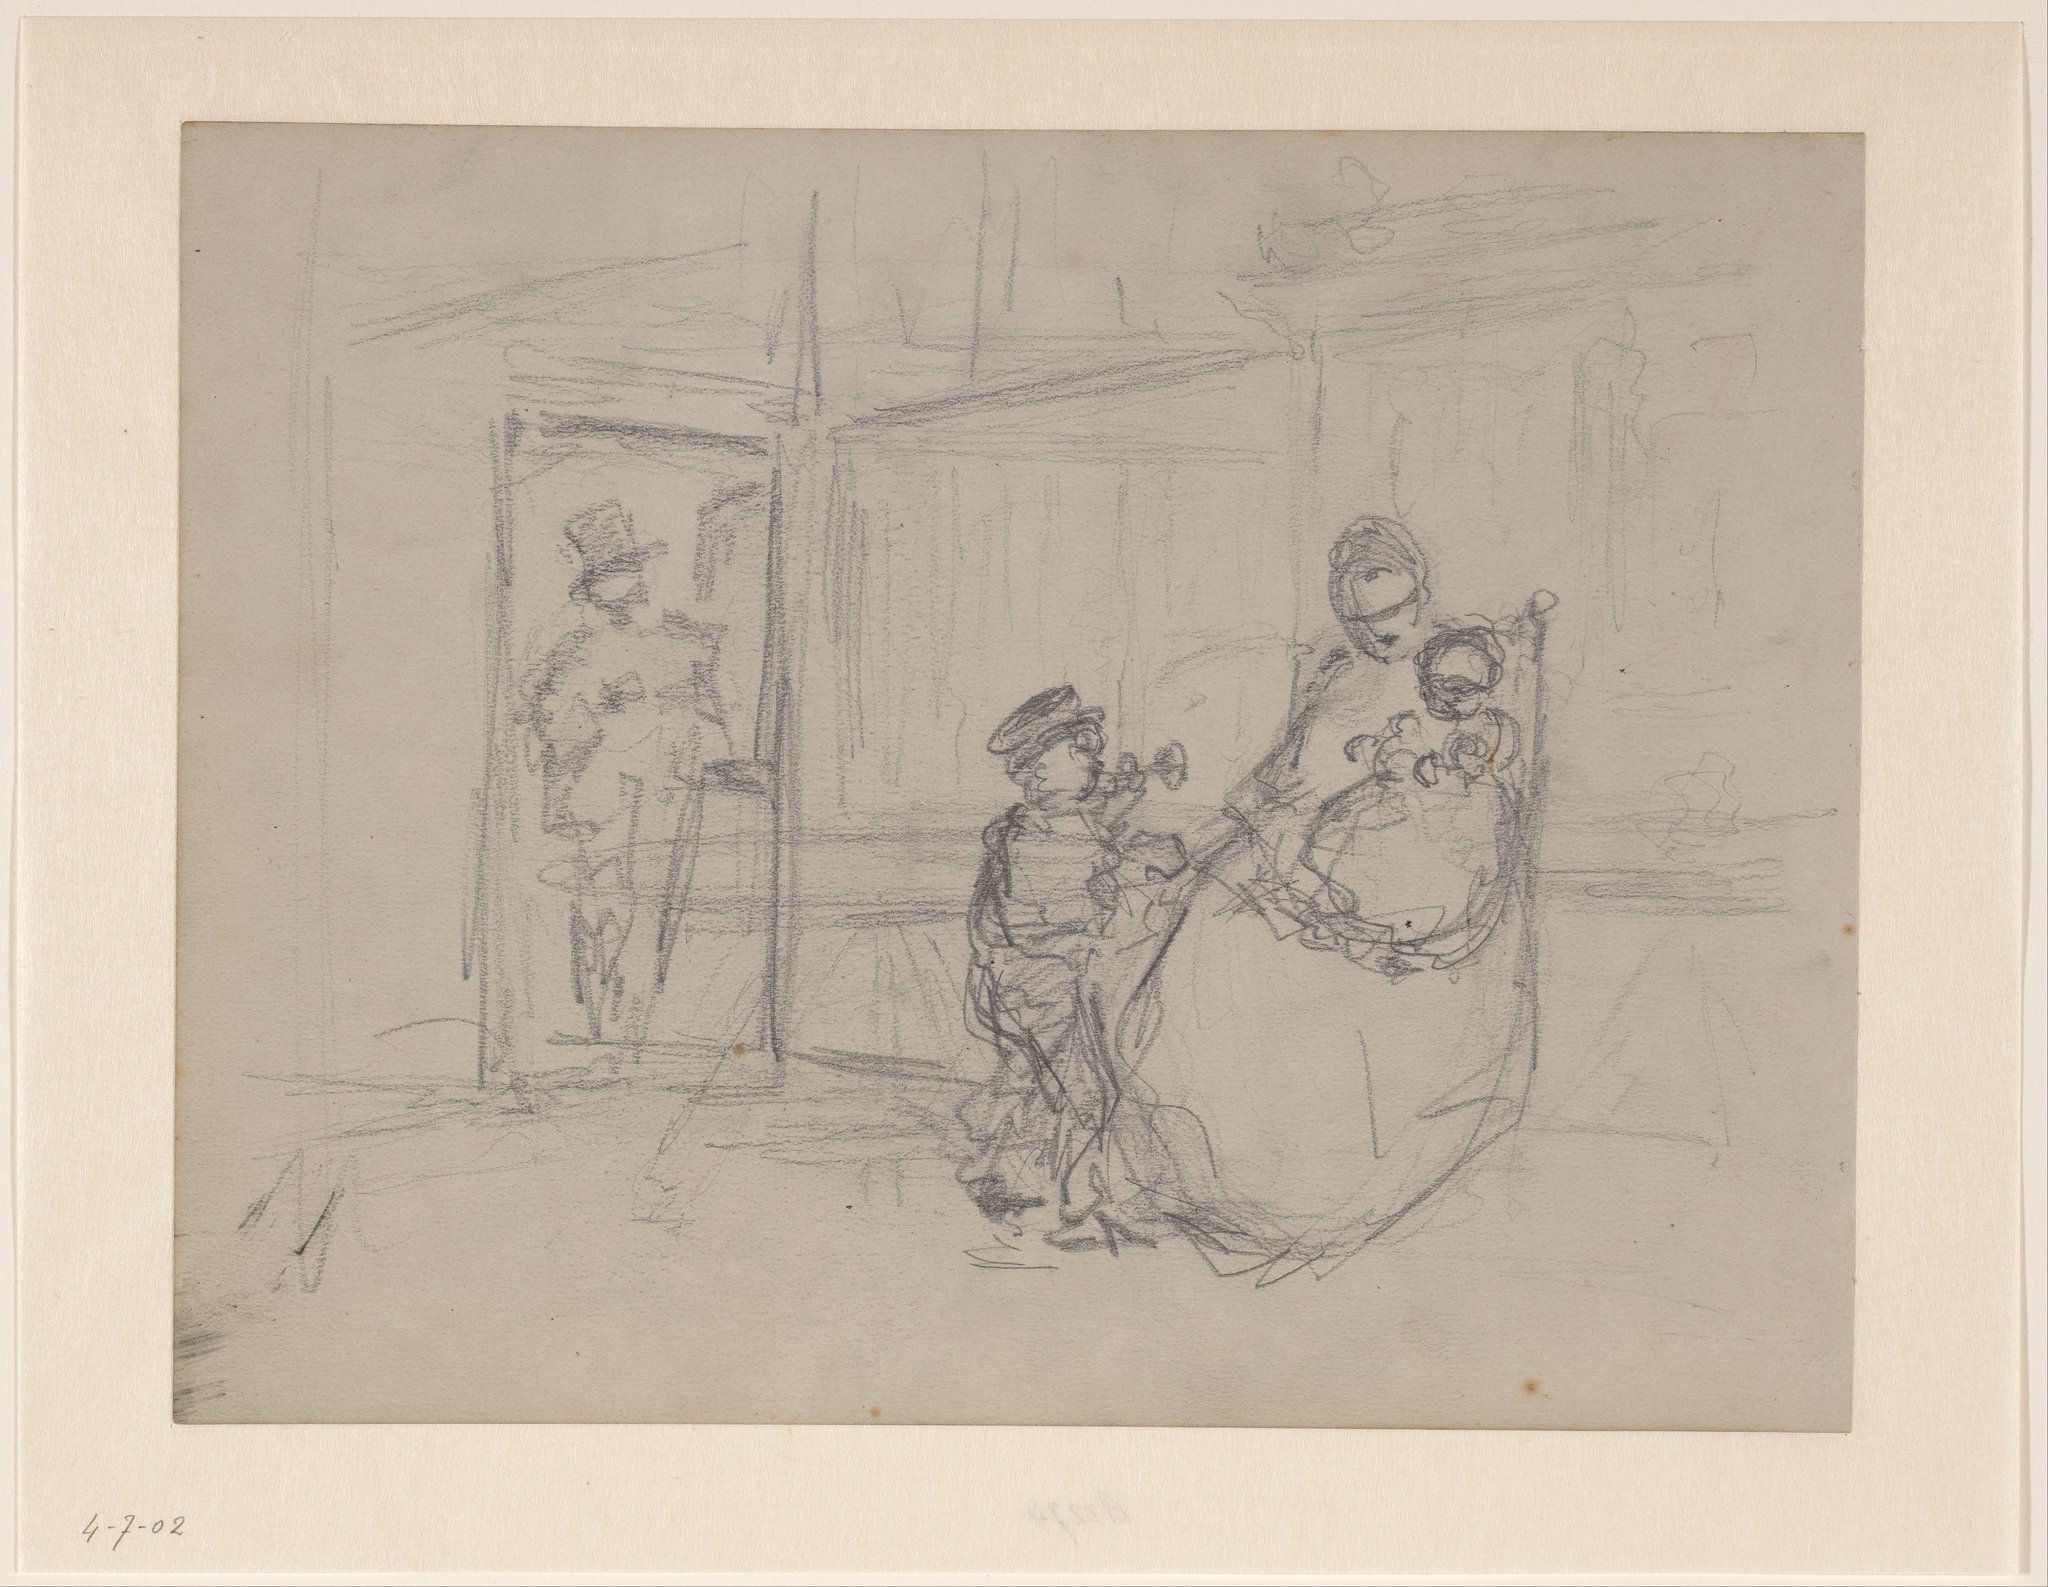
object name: drawing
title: Interieur met moeder, kinderen en een man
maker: hendrik valkenburg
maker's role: draughtsman, painter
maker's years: 1826-1896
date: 1836-1896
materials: chalk, paper, pencil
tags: boy (child between toddler and youth), family group, especially parents with their child(ren)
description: Interieur met moeder, kinderen en een man in de deuropening. Verso: jongetje op een stoel met hoed in de hand.